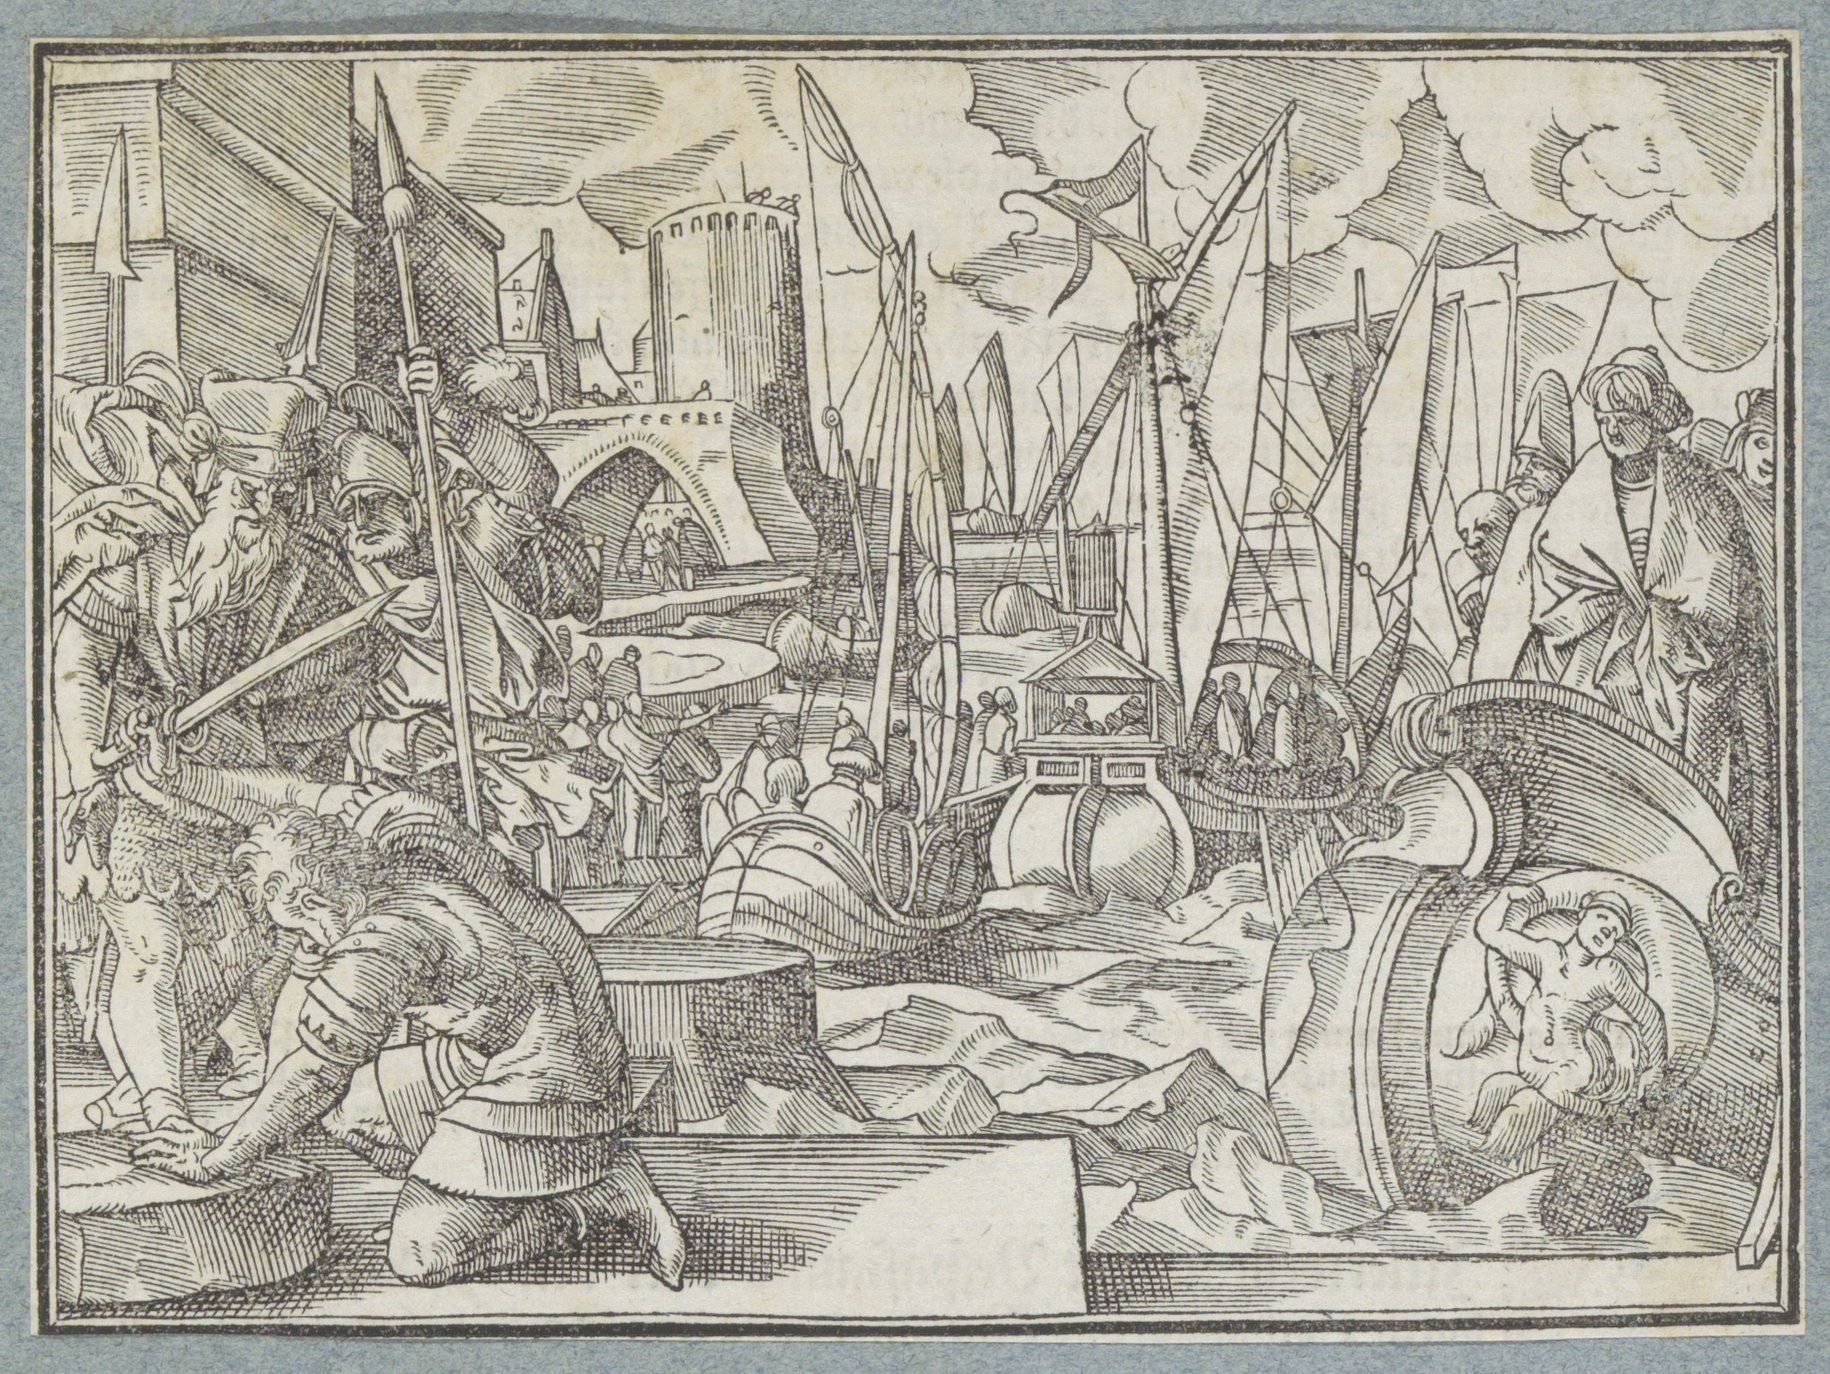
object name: print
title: Josefus in een boot voor de stad Tiberias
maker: christoffel van sichem (i)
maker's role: print maker, publisher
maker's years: 1546-1624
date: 1574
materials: paper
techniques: letterpress printing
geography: amsterdam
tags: harbour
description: Boekillustratie voor een editie van: Flavius Josephus, Von Alten Jüdischen Geschichten. De eerste editie verscheen in 1574.